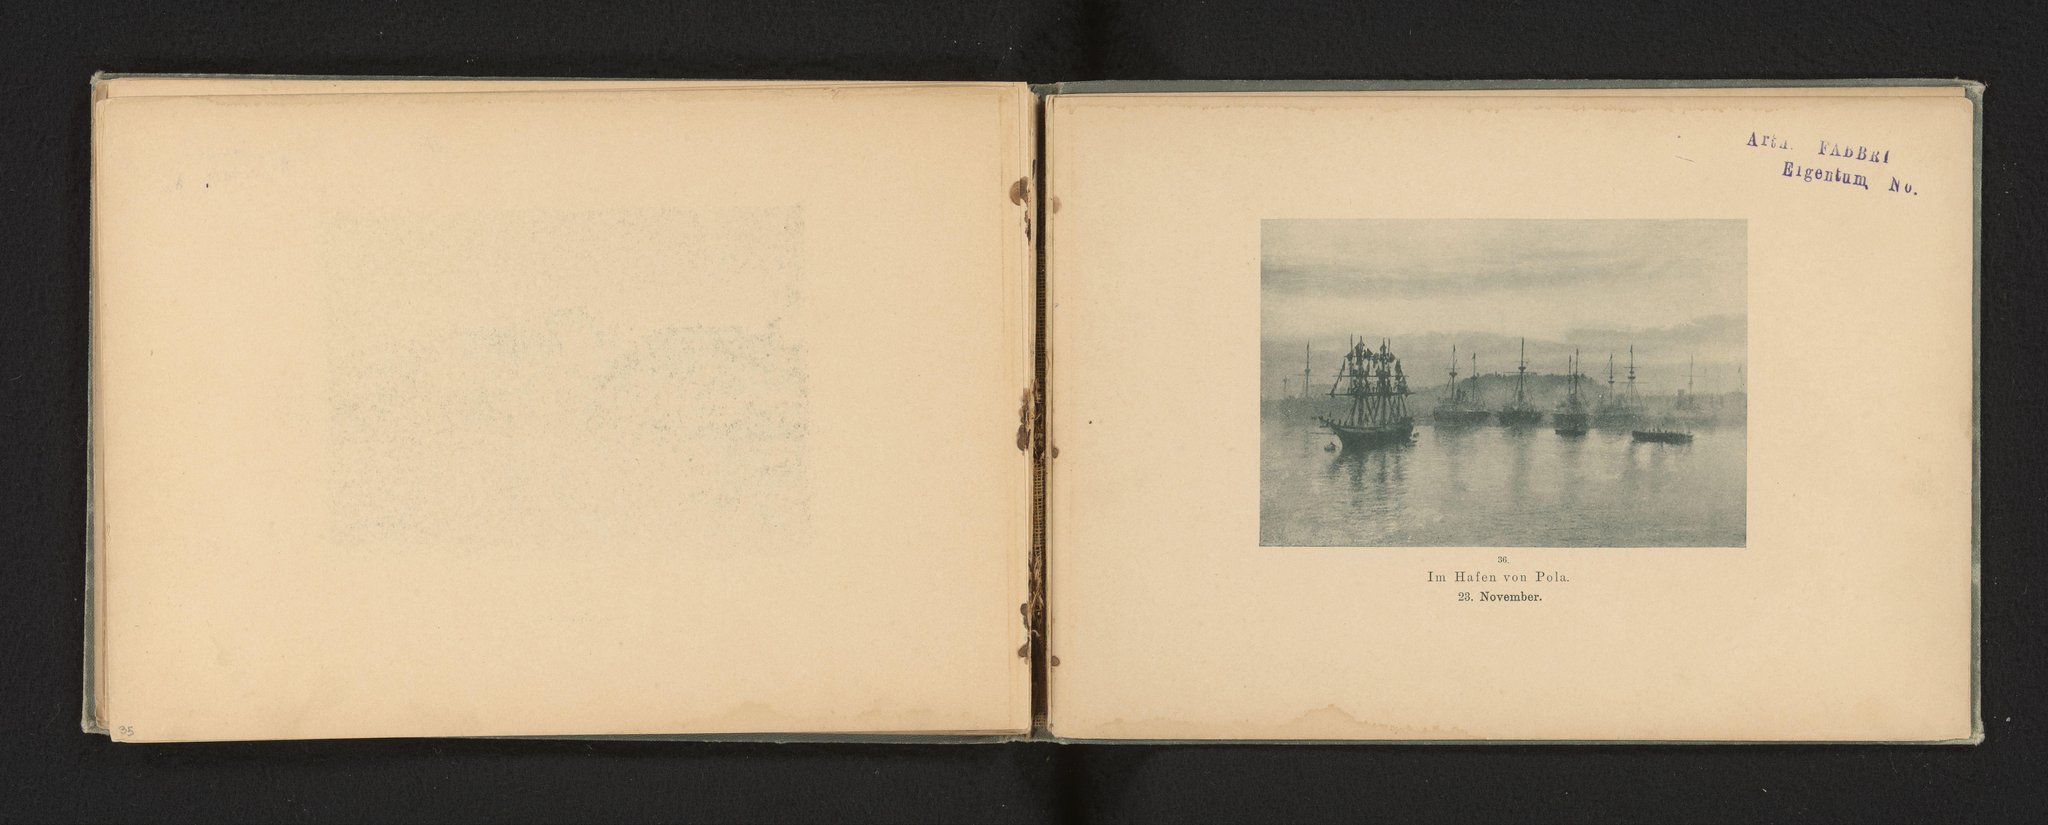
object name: photomechanical print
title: Im Hafen von Pola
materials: paper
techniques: photograph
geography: santa pola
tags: harbour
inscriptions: collector's mark: ‘Art[h]. FA[B]BRI/ Eigentum No.’, number: ‘36.’